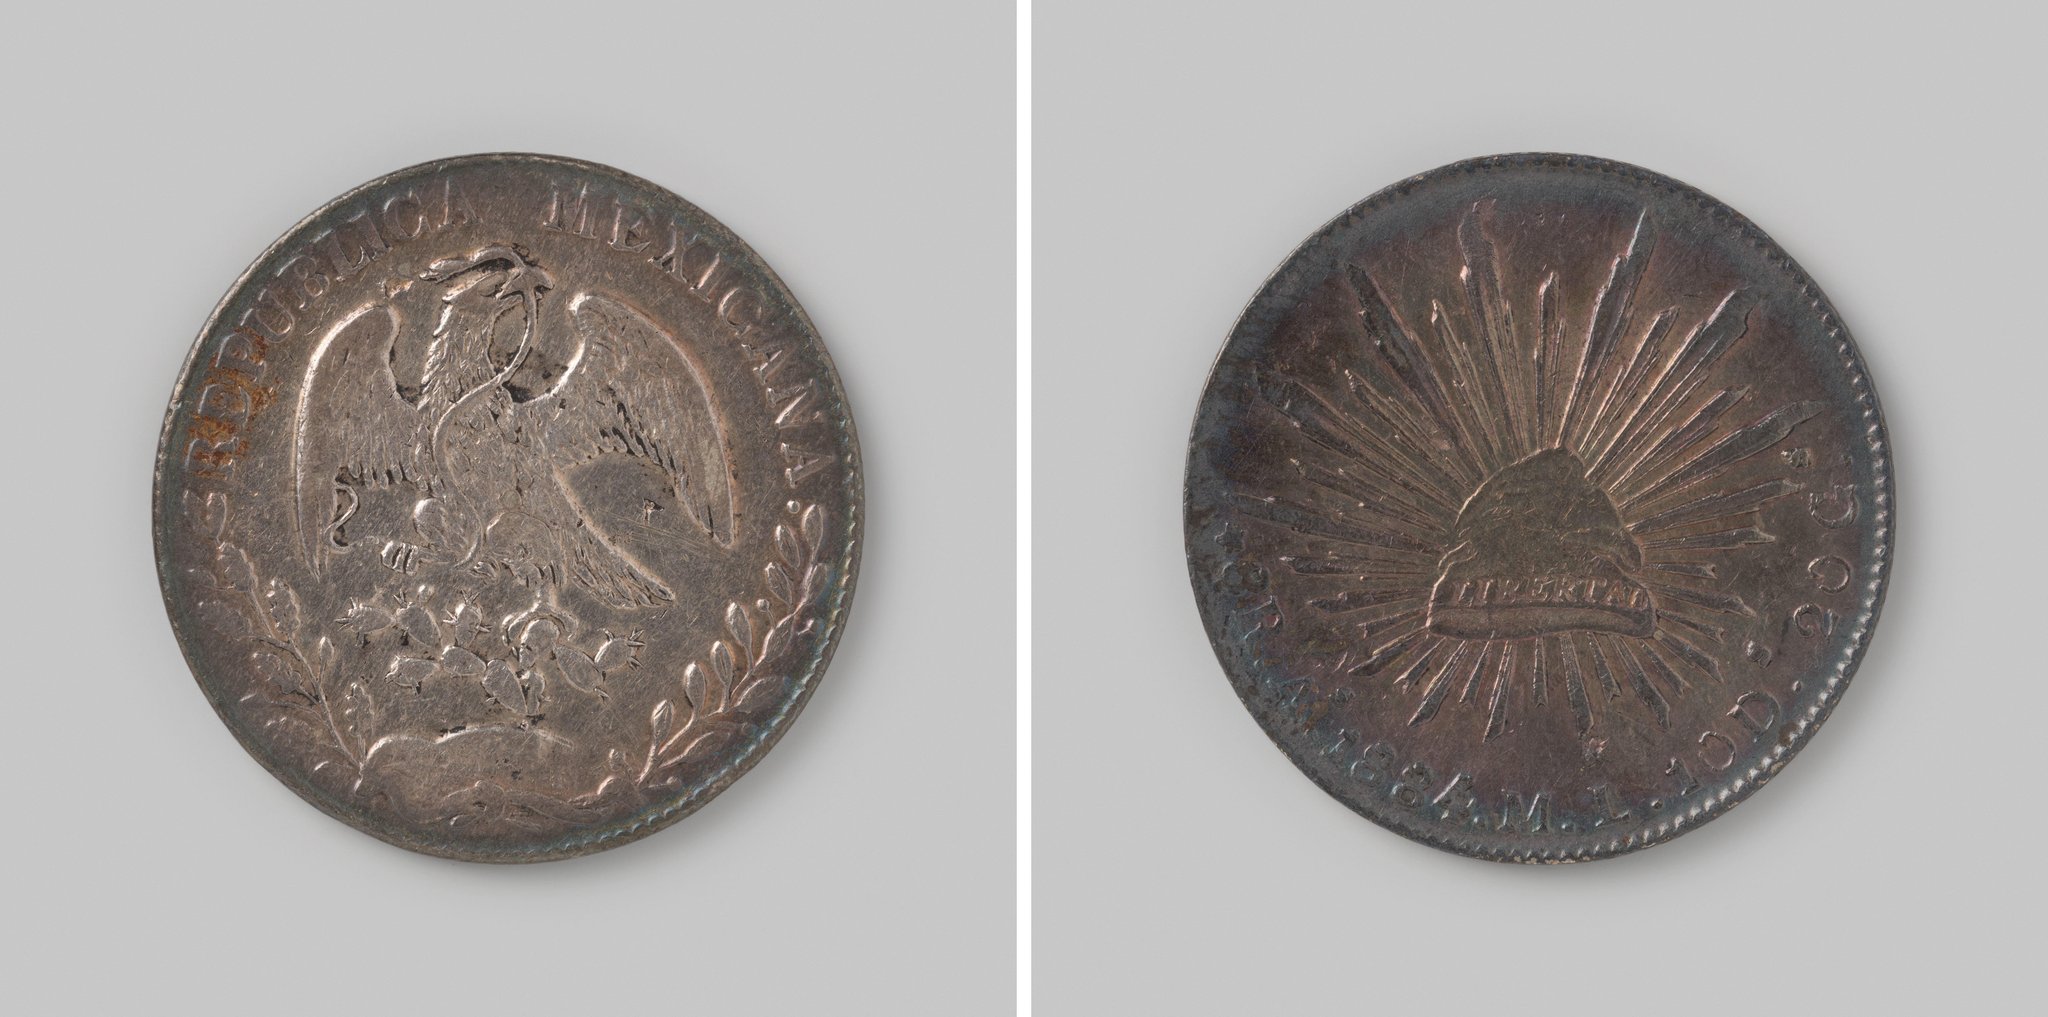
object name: coin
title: Peso of acht reaal uit Mexico ((Álamos),1884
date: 1884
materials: silver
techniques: striking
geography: los alamos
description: Zilveren munt. Voorzijde: tussen twee samengebonden takken op cactusplant staande adelaar met gespreide vleugels met zijn kop naar rechts met in zijn bek een slang. Keerzijde: vrijheidshoed, waaruit stralen te voorschijn komen. In omschrift waarde-aanduiding: 8R en muntplaats-aanduiding: As [=Alamos] met jaartal linksonder. Kabelrand.